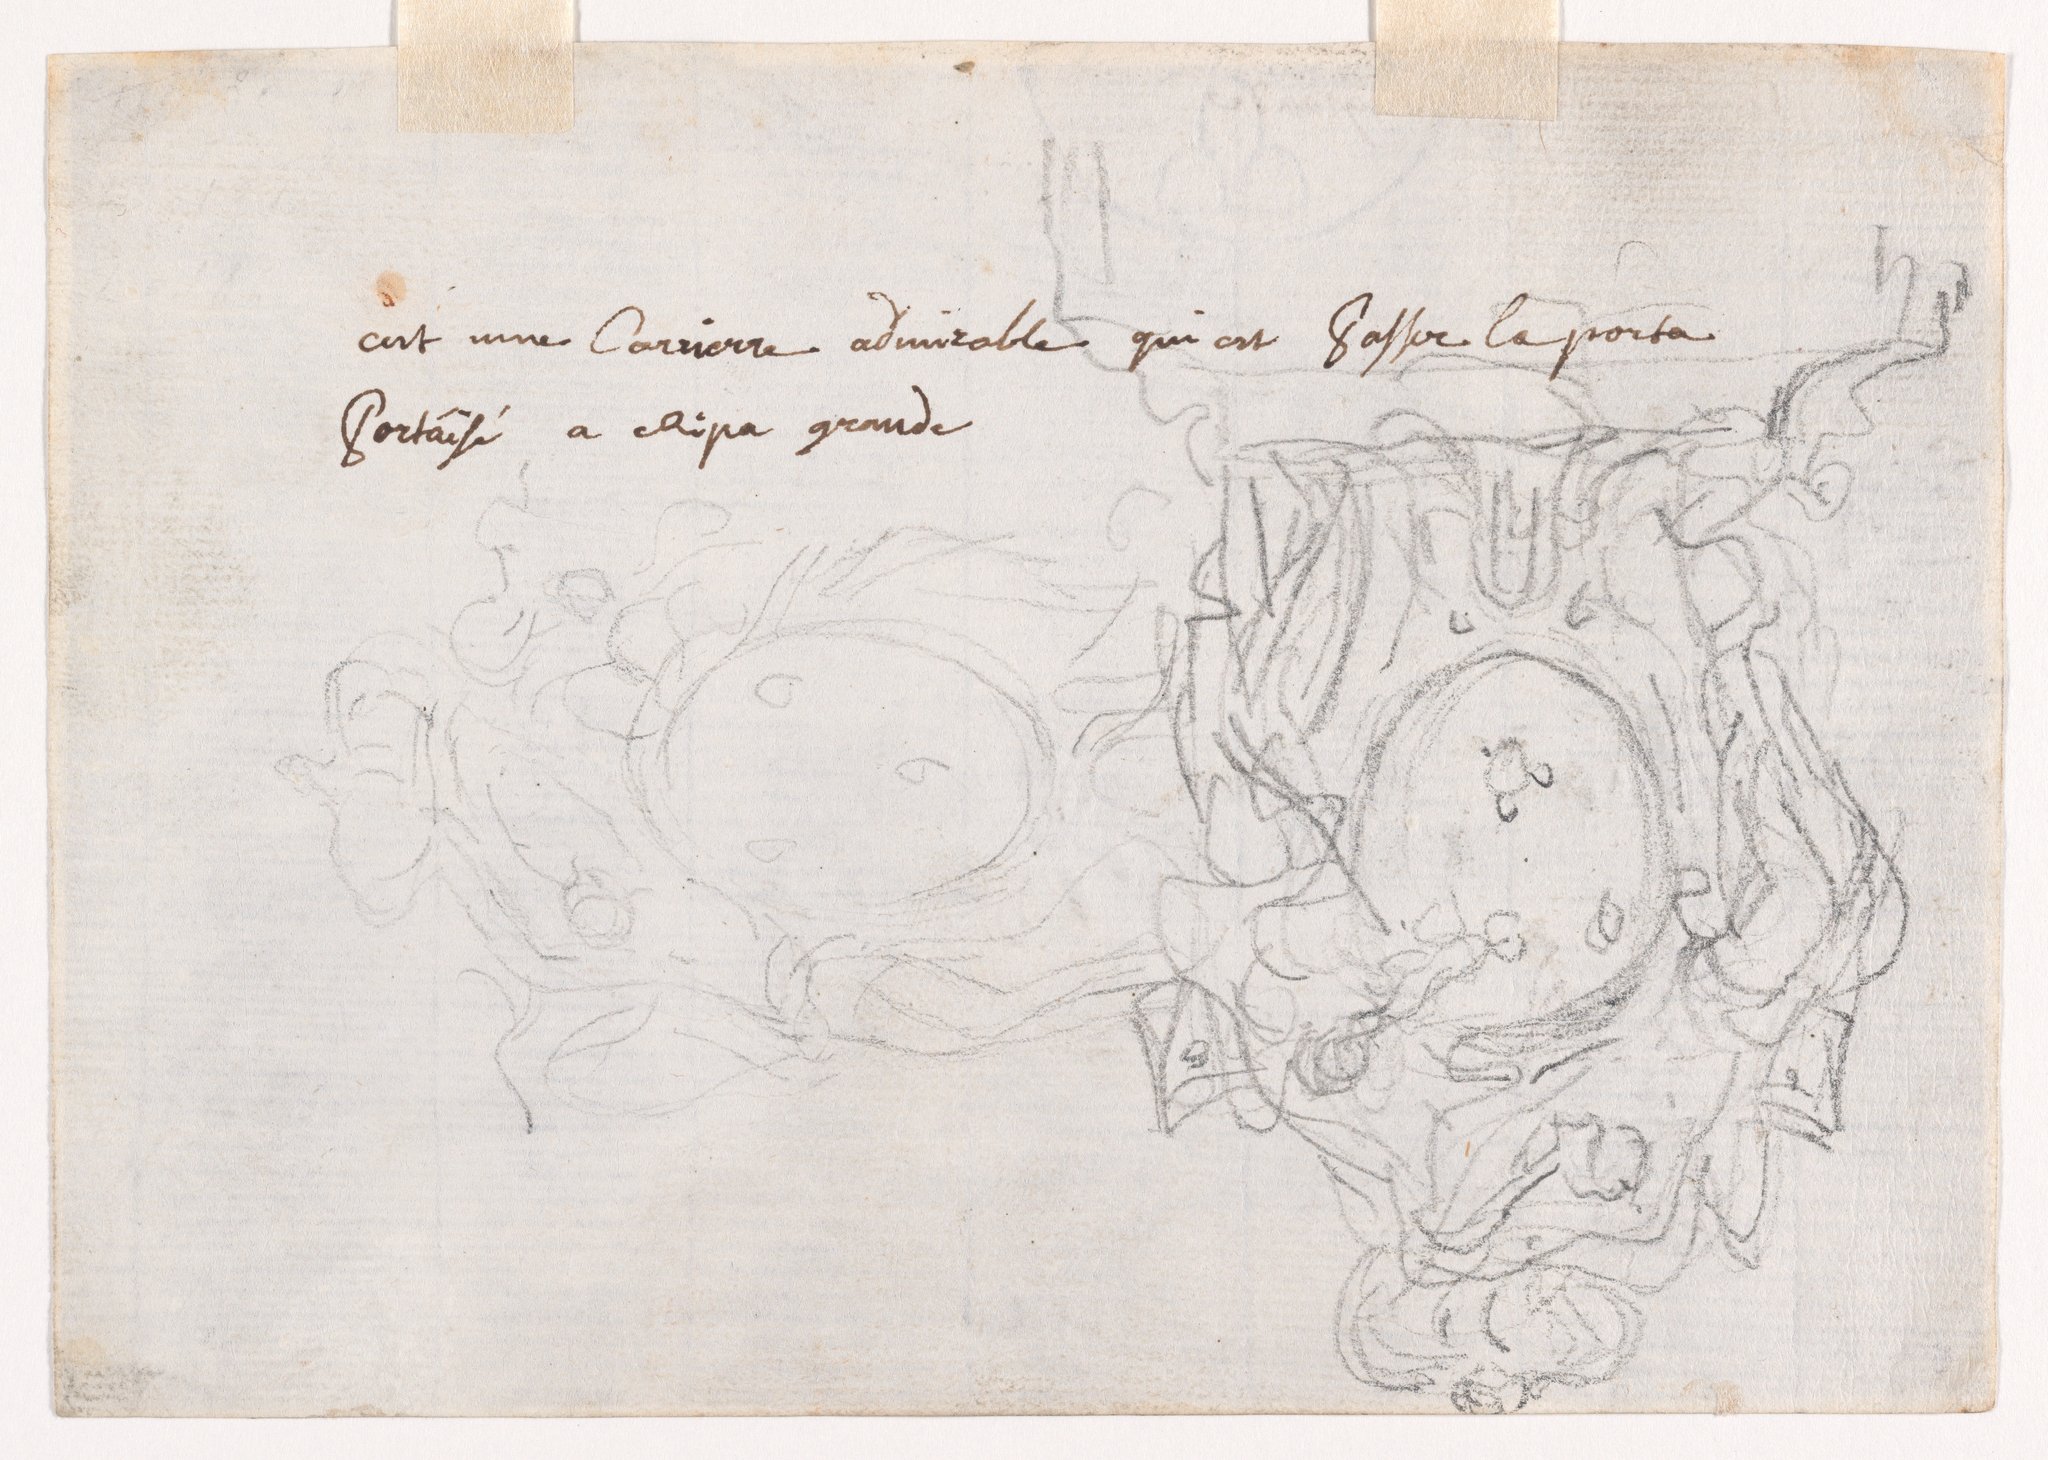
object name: drawing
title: Rocky Landscape with Figures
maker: augustin pajou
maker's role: artist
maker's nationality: french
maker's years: 1730-1809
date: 1752-1756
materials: chalk